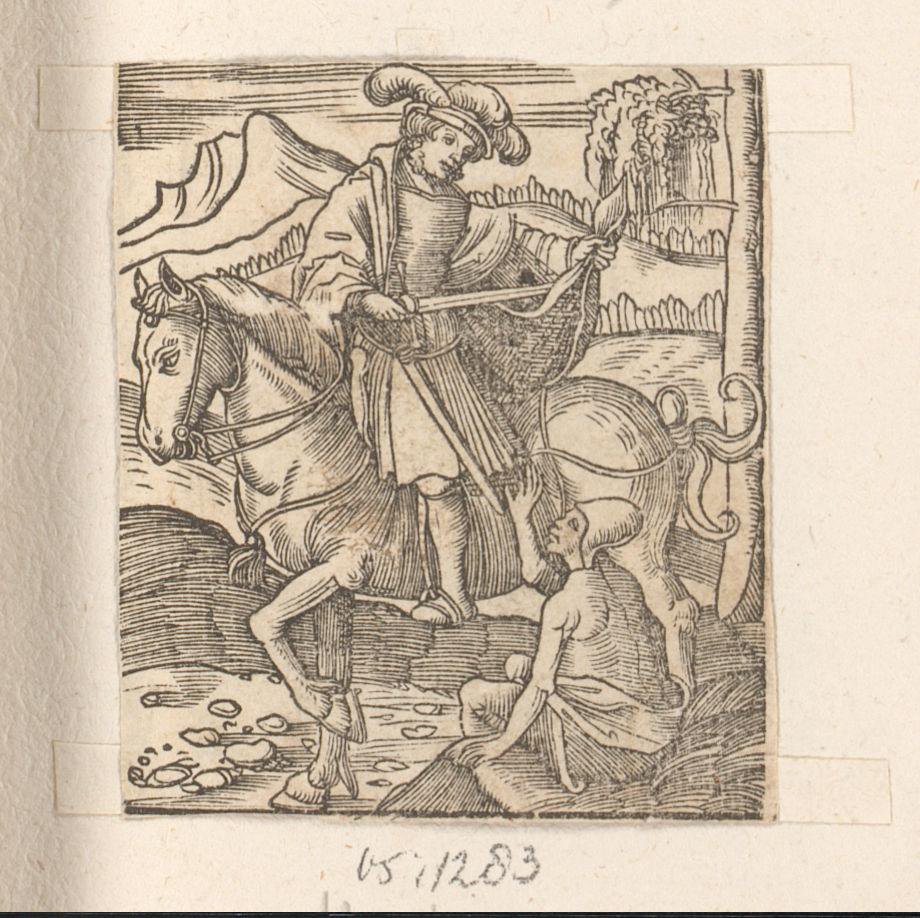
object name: book illustration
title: H. Martinus deelt zijn mantel met een bedelaar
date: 1515-1517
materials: paper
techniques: woodcut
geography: nuremberg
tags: st. martin divides his cloak (i.e. the charity of st. martin): he is usually shown on horseback, cutting his cloak with his sword, or putting part of the cloak round the shoulders of a beggar who kneels beside him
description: Gezeten op zijn paard snijdt de Heilige Martinus met zijn zwaard zijn mantel in tweeën, om een deel aan een bedelaar te geven. Prent maakt deel uit van een album.